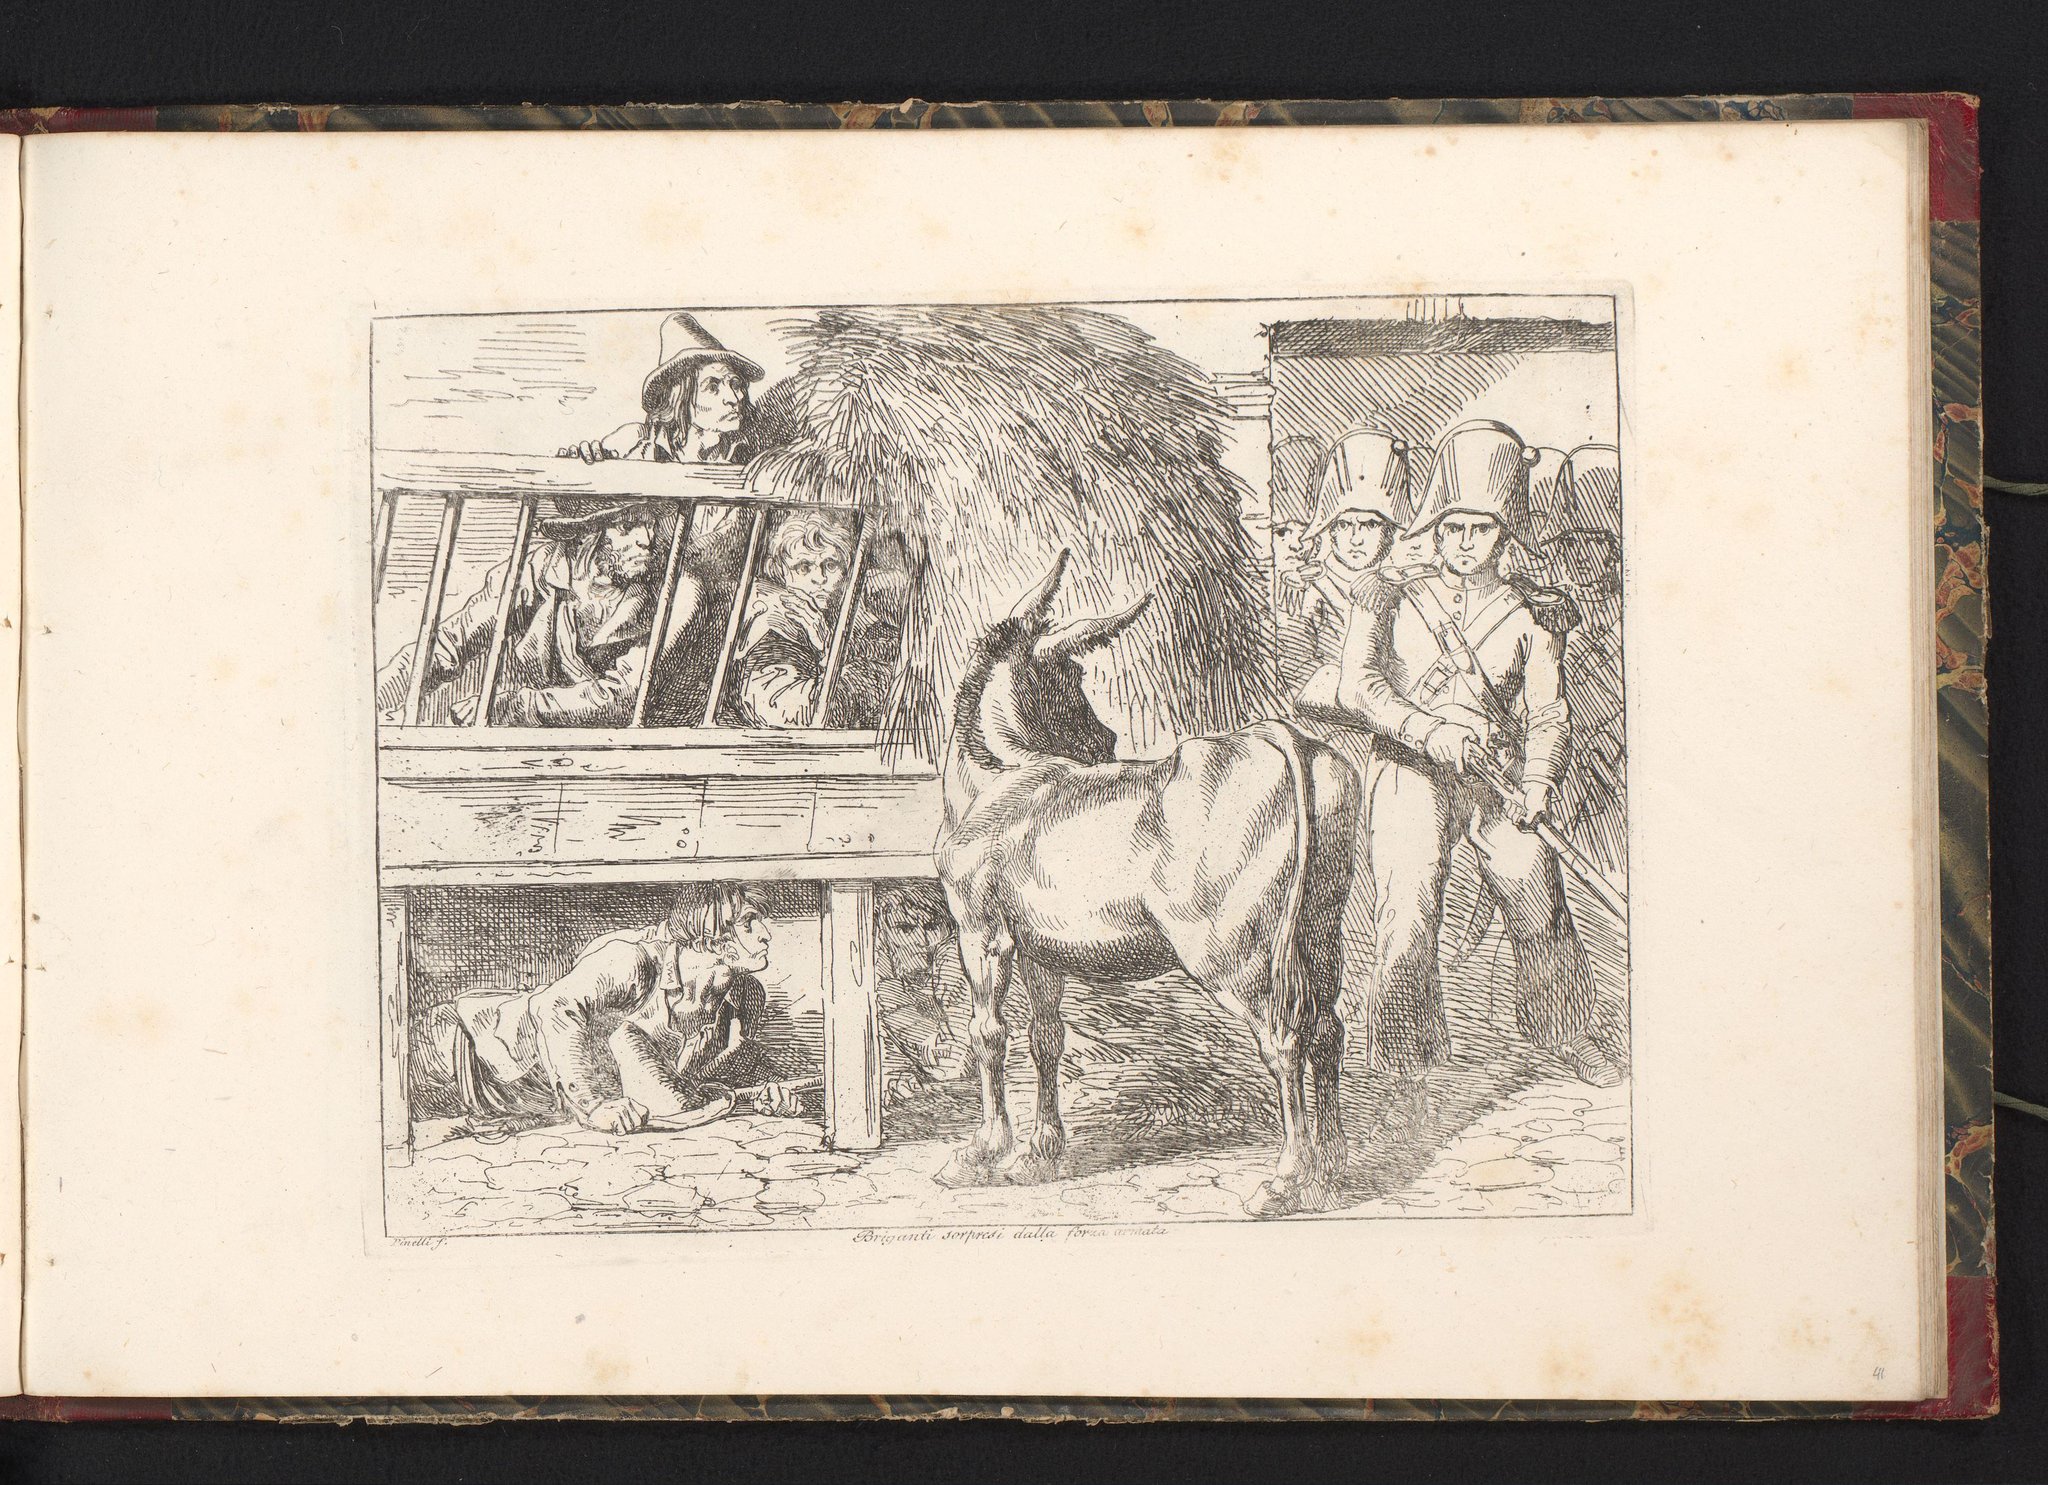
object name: album leaf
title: Briganti sorpresi dalla forza armata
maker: bartolomeo pinelli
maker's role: draughtsman, print maker, sculptor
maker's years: 1781-1835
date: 1819-1823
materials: paper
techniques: etching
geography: rome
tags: ass, donkey, robber, folk costume, regional costume, stall, stable, hiding, hiding oneself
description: In een stal verstoppen vijf bandieten zich achter een hooiberg. Rechts komt een groep gewapende mannen de stal binnen. Op de voorgrond staat een ezel. De prent maakt deel uit van een album.